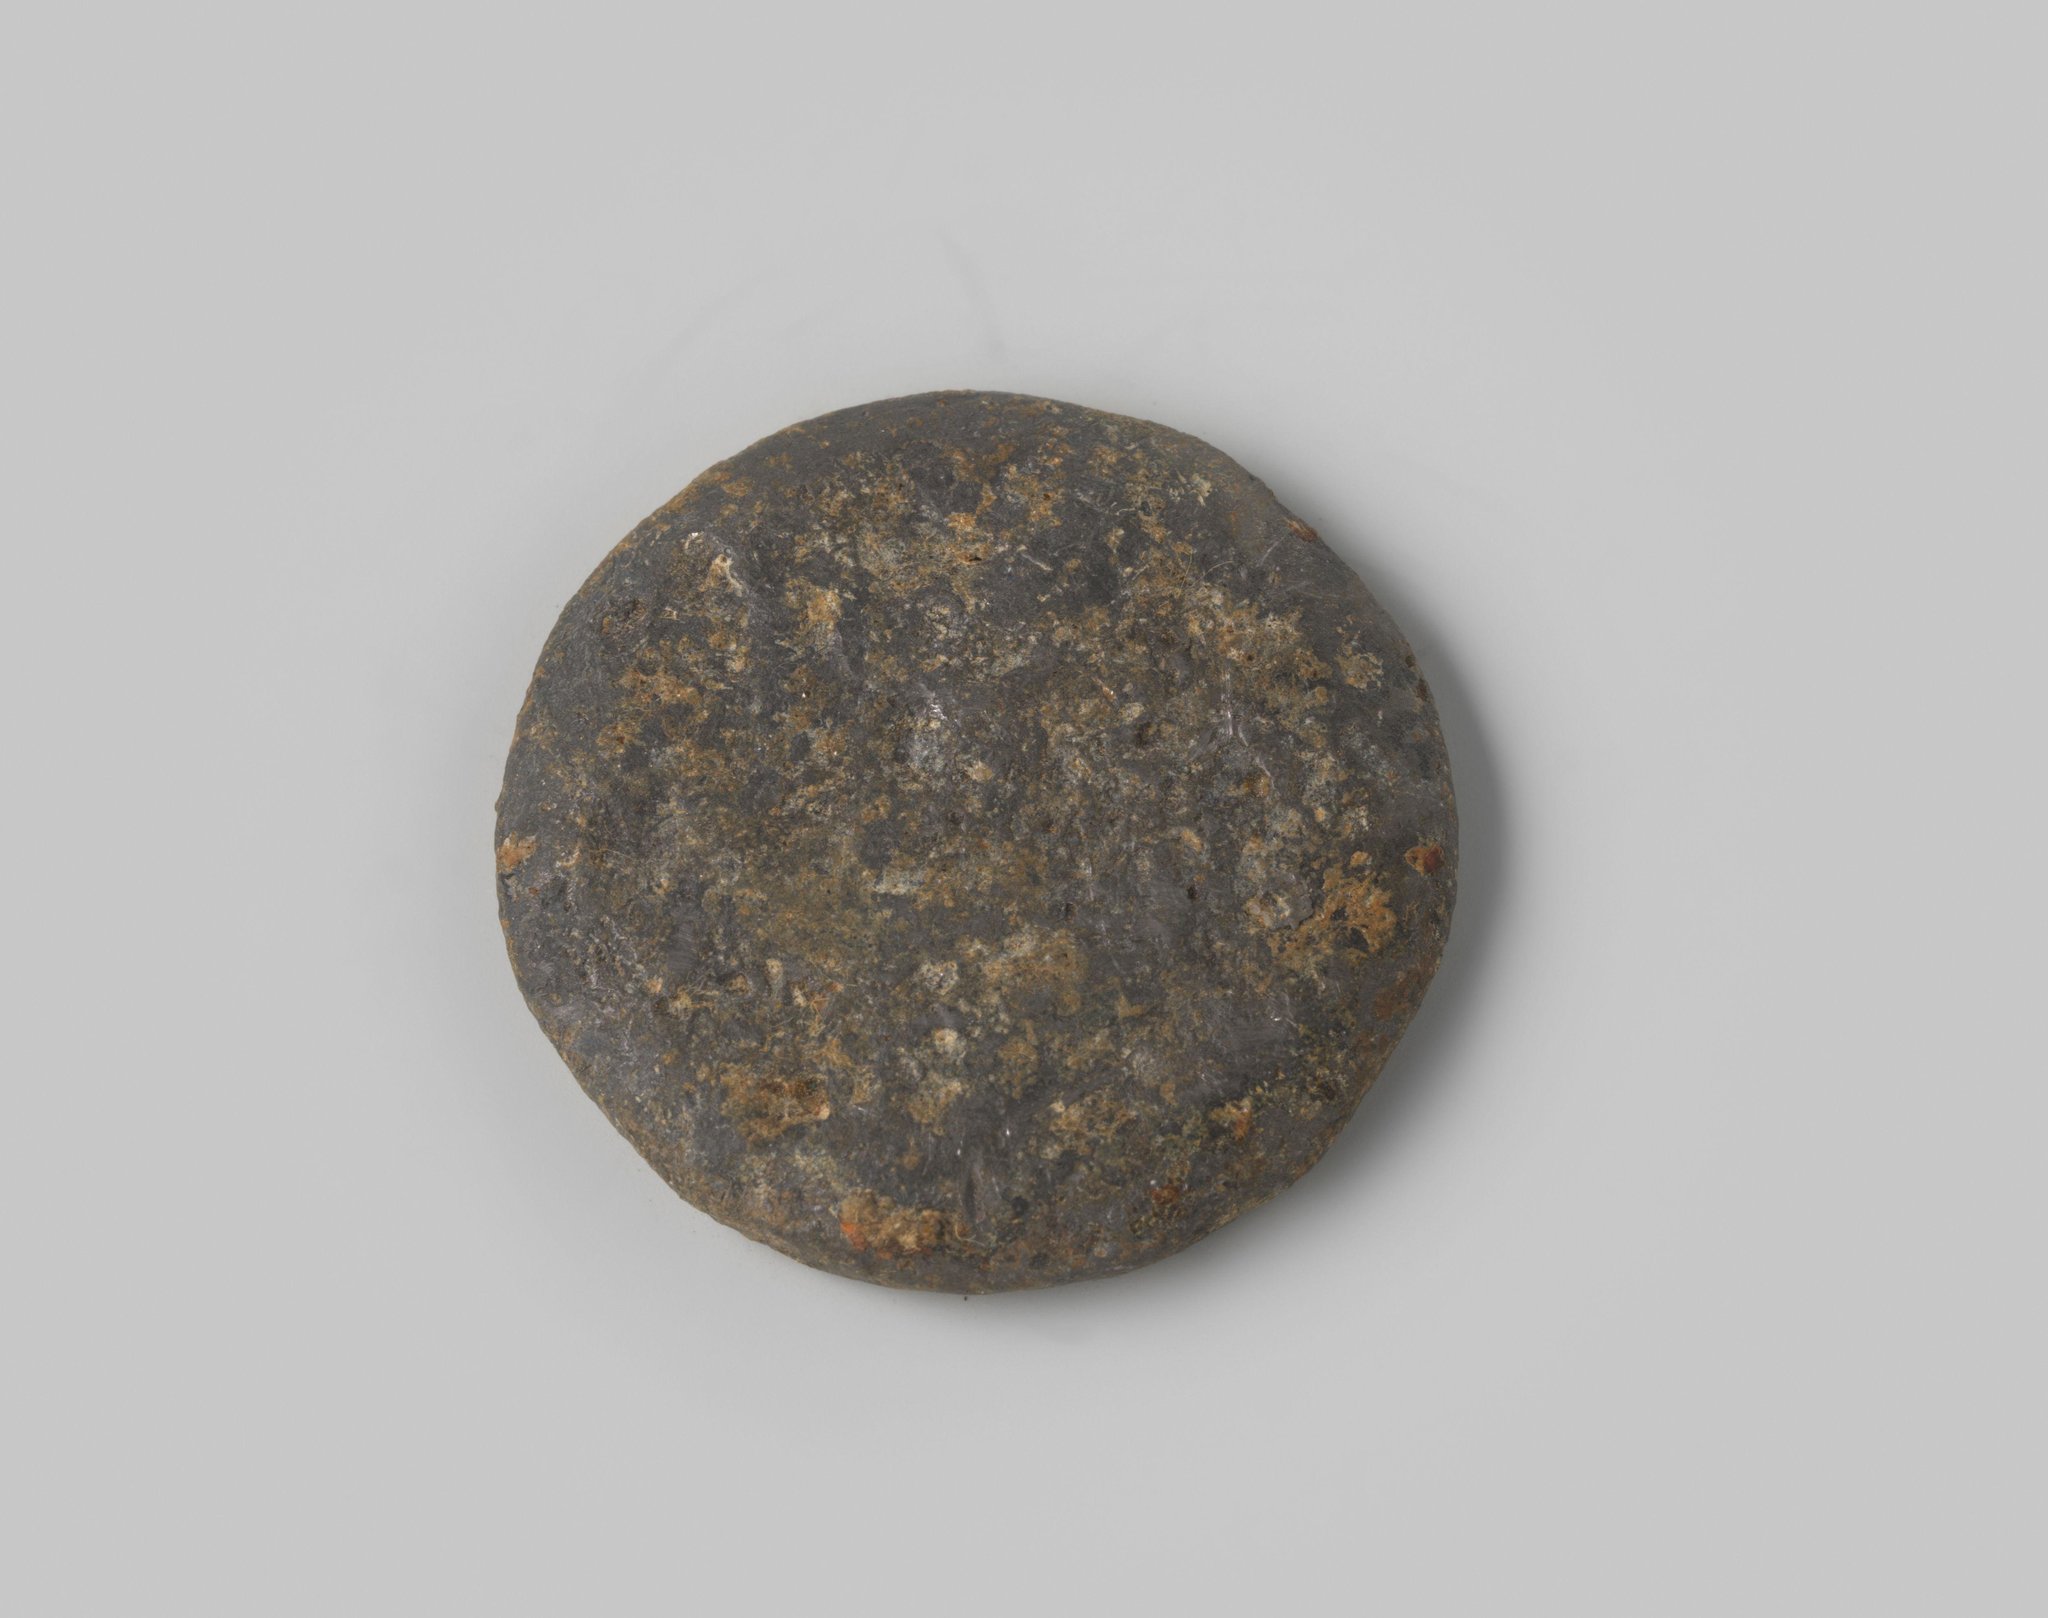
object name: weight scale component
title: Gewicht uit het wrak van de Oost-Indiëvaarder Hollandia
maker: Anonymous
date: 1700-1743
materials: lead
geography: netherlands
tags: verenigde oostindische compagnie, hollandia (schip), annet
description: Disc-shaped weight, circular, flat top and underside, rounded edge.